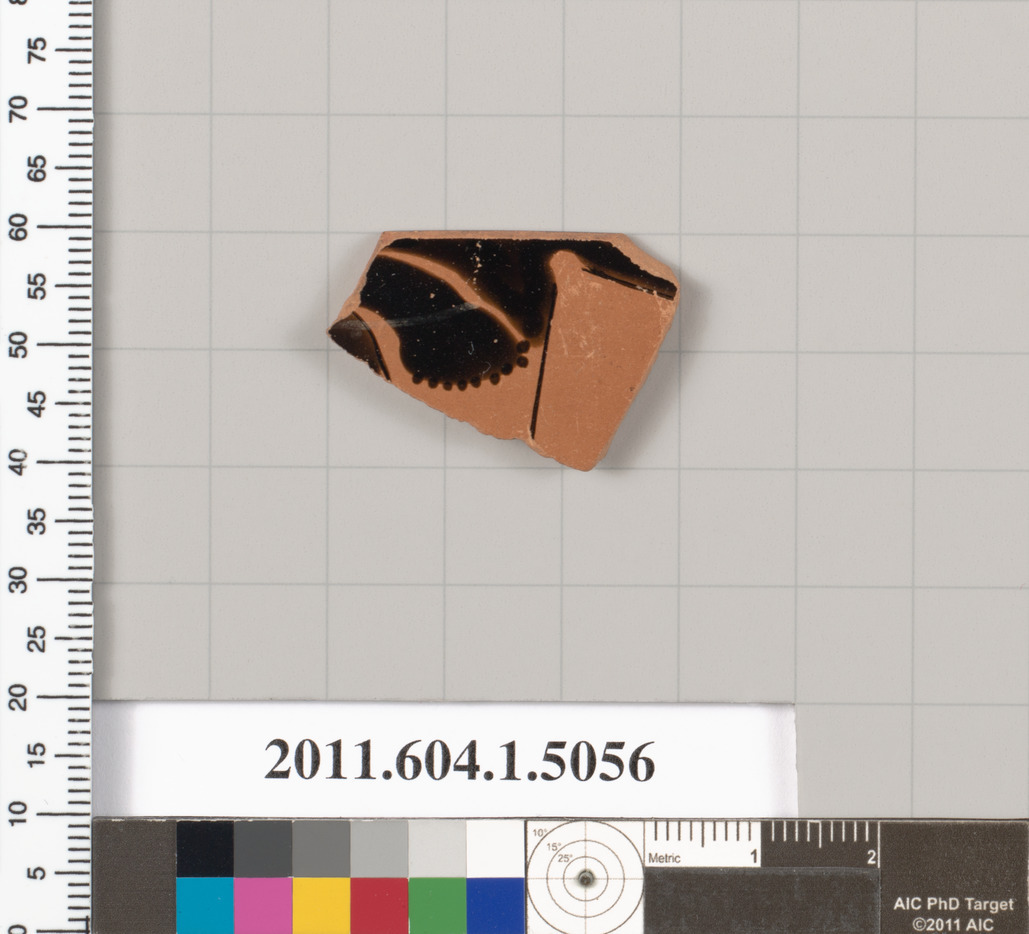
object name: kylix fragment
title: Terracotta fragment of a kylix (drinking cup)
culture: greek, attic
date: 520-500 BCE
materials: terracotta